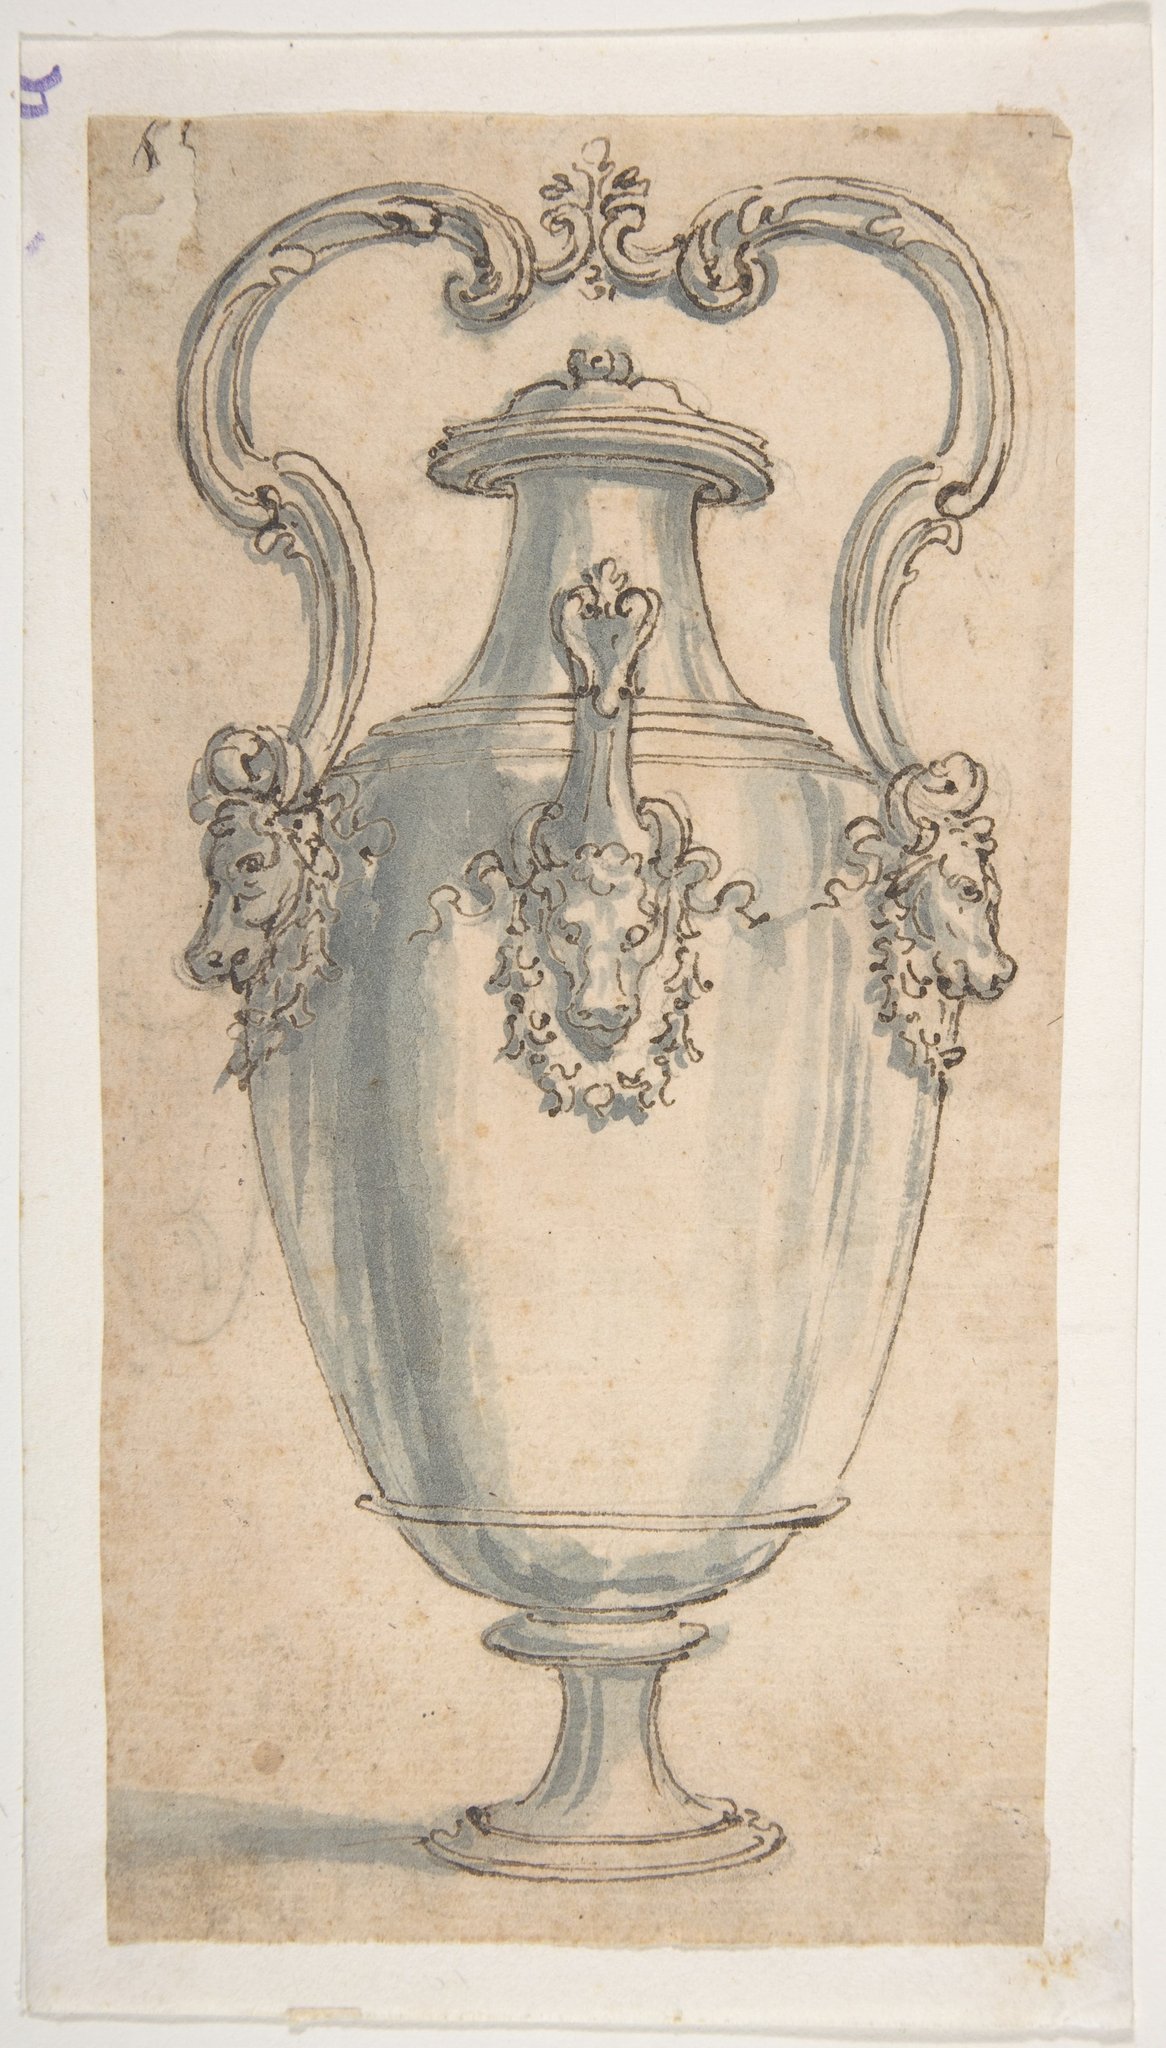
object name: drawing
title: Design for a Ewer with Bull Heads under the Handles and Spout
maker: giovanni battista foggini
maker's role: artist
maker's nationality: italian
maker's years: 1652-1725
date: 1672-1725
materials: chalk, ink, paper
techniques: brush, pen, wash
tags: bulls,ewers